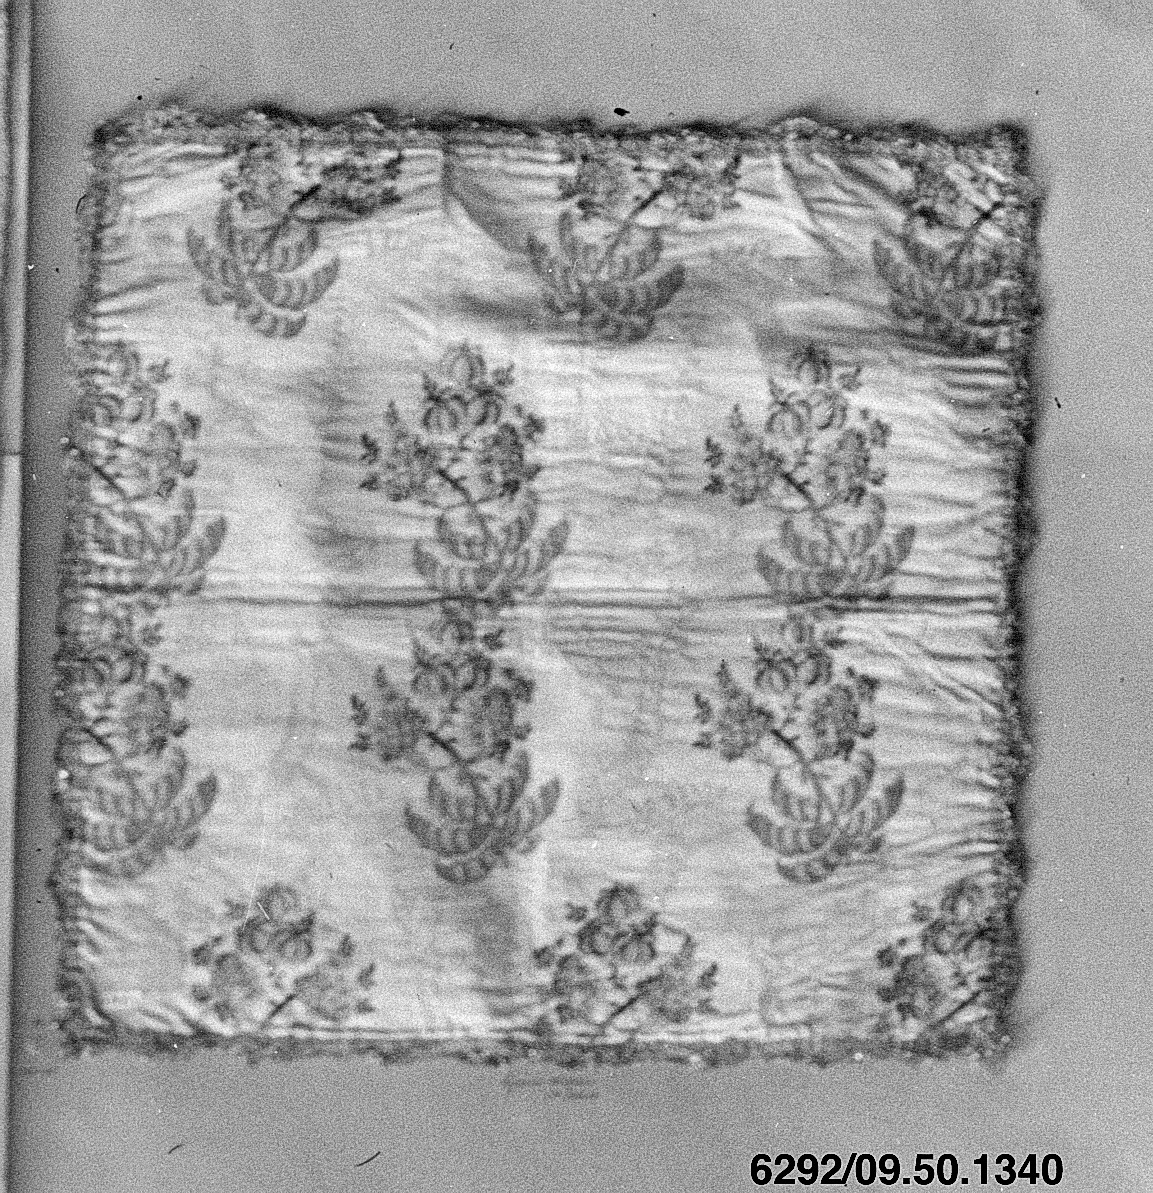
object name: piece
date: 1760-1770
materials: silk